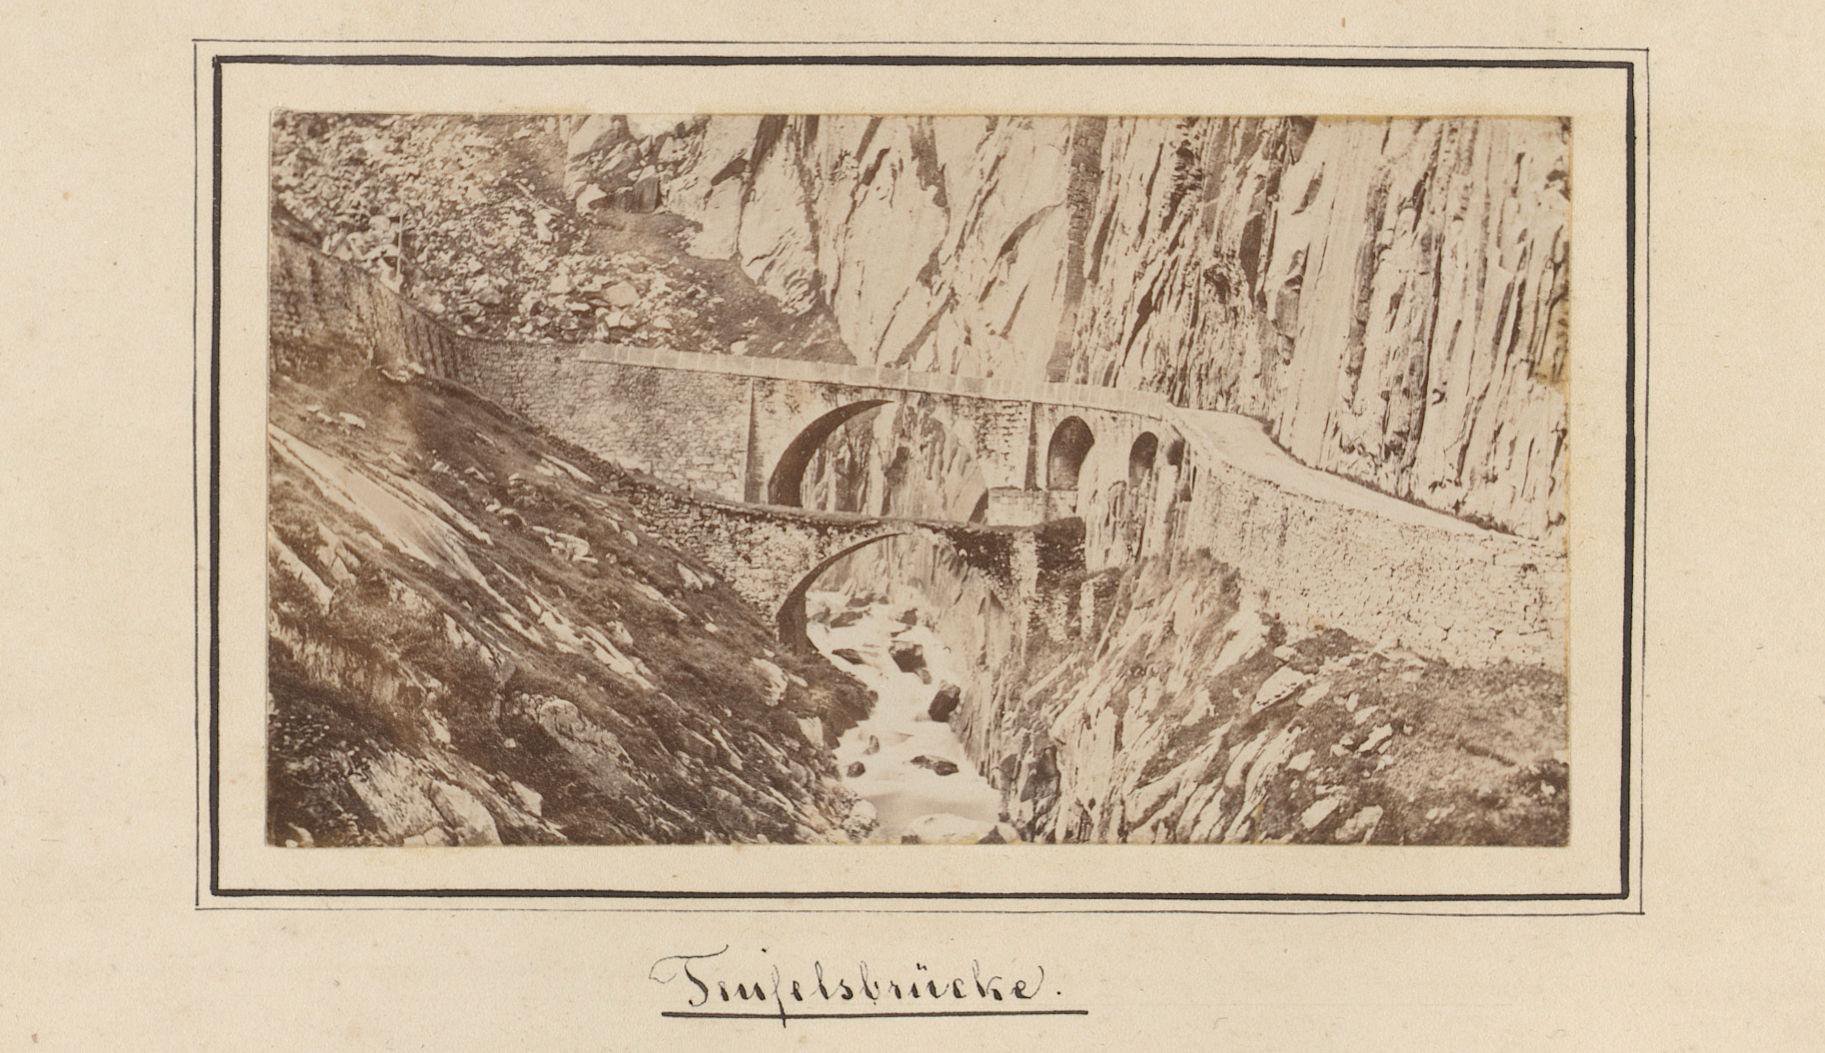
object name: photograph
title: Teufelsbrücke in Zwitserland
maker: Anonymous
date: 1870-1890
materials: paper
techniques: albumen print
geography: teufelsbrücke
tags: bridge